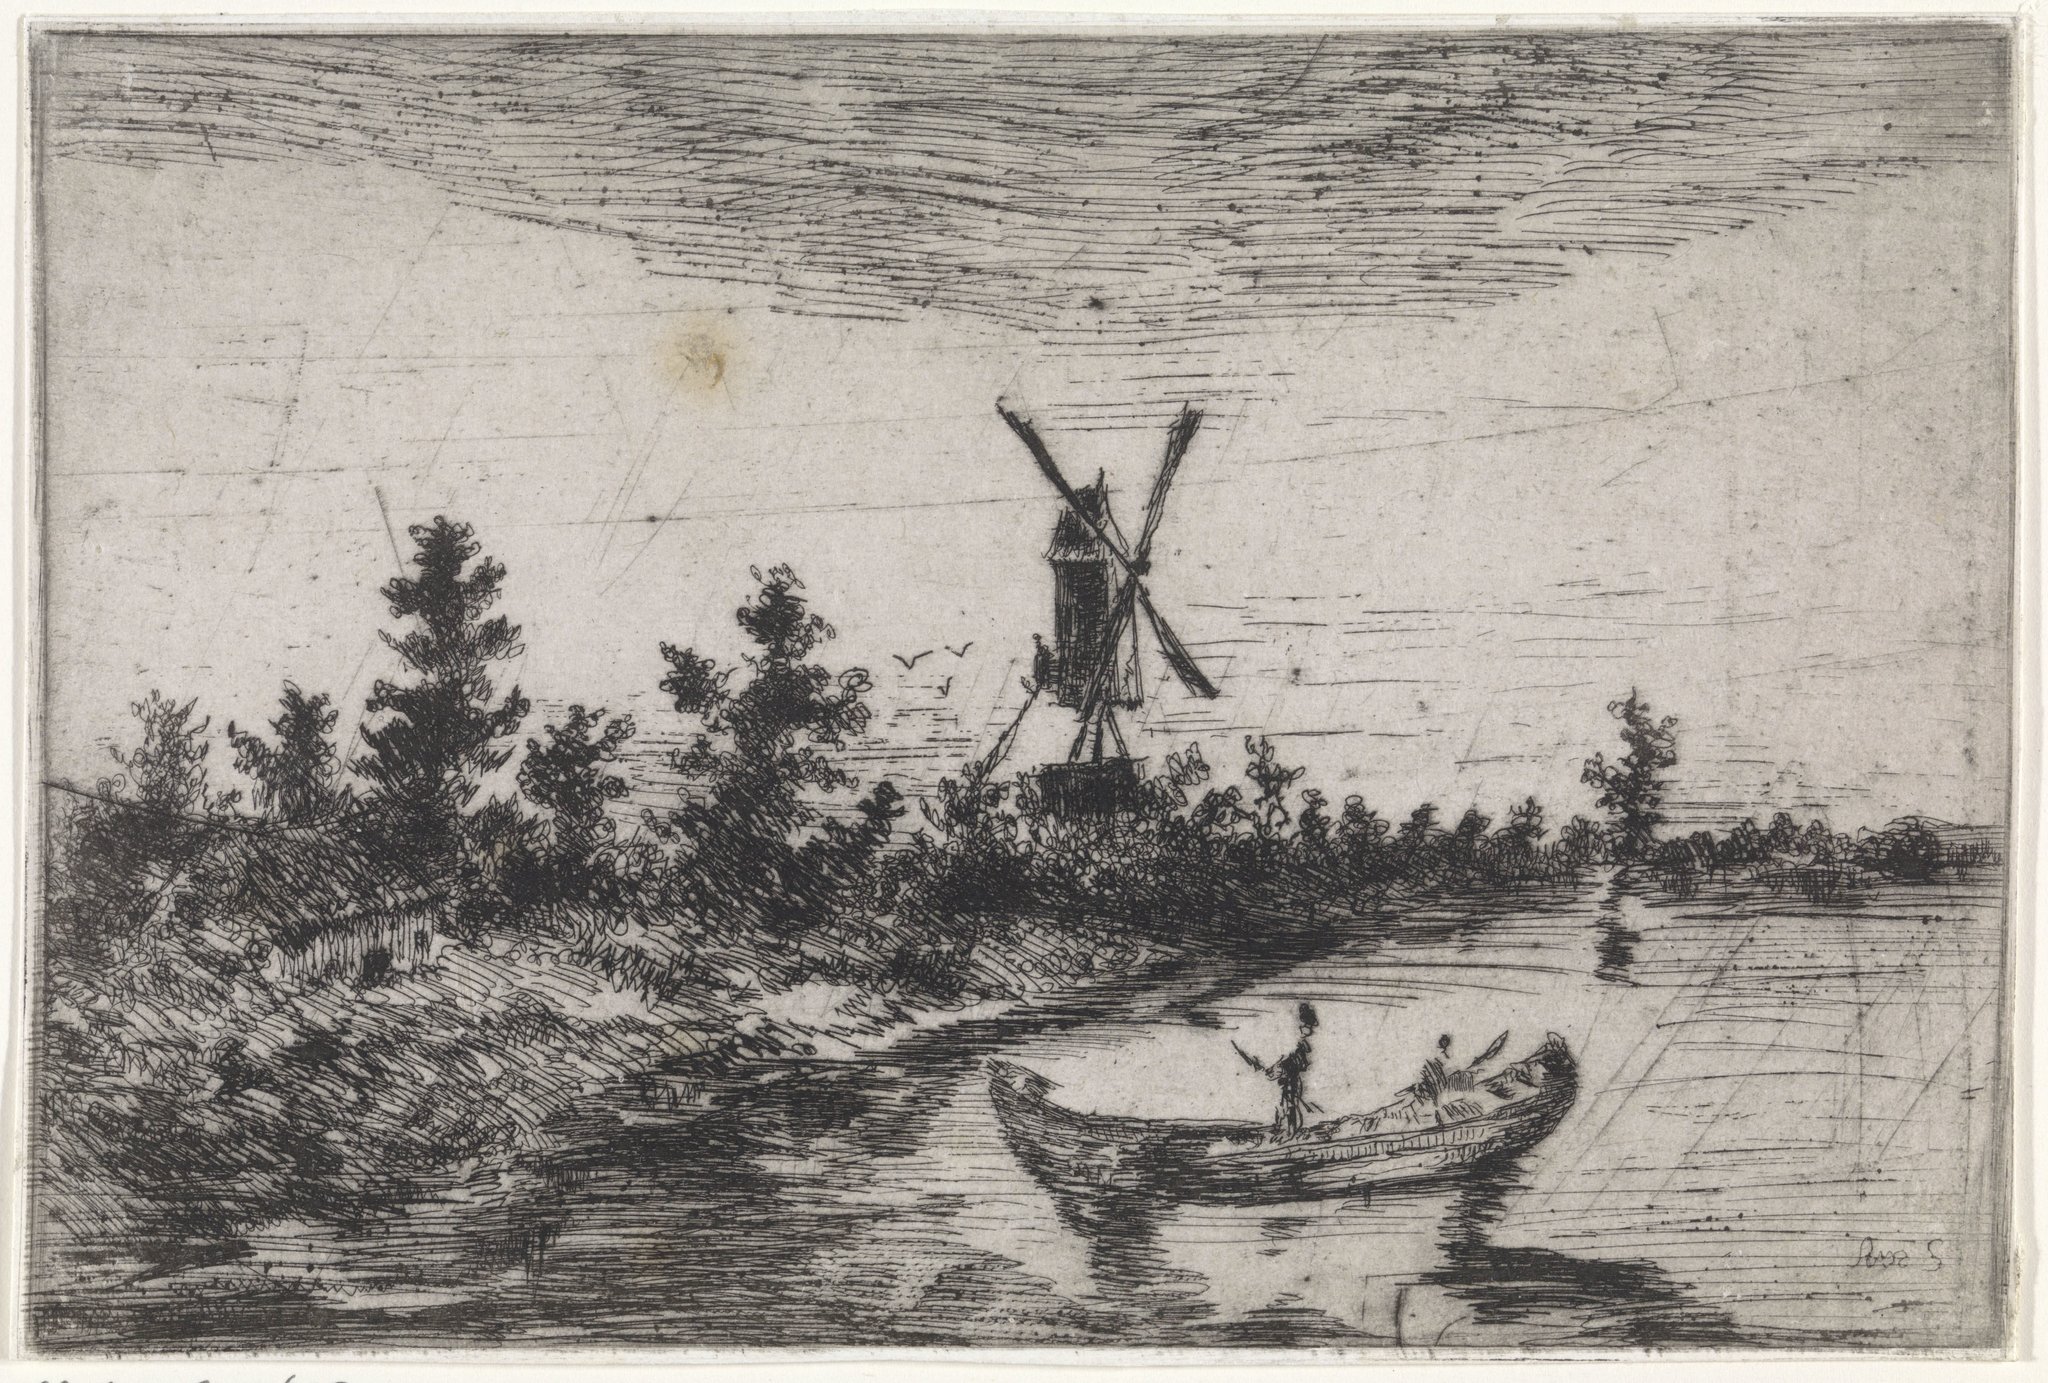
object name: print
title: Landschap met molen en boot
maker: arnoud schaepkens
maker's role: print maker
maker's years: 1816-1904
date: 1855-1904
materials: paper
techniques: drypoint, etching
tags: landscapes with waters, waterscapes, seascapes (in the temperate zone), rowing-boat, canoe, etc., windmill in landscape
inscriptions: collector's mark: Lugt 2228